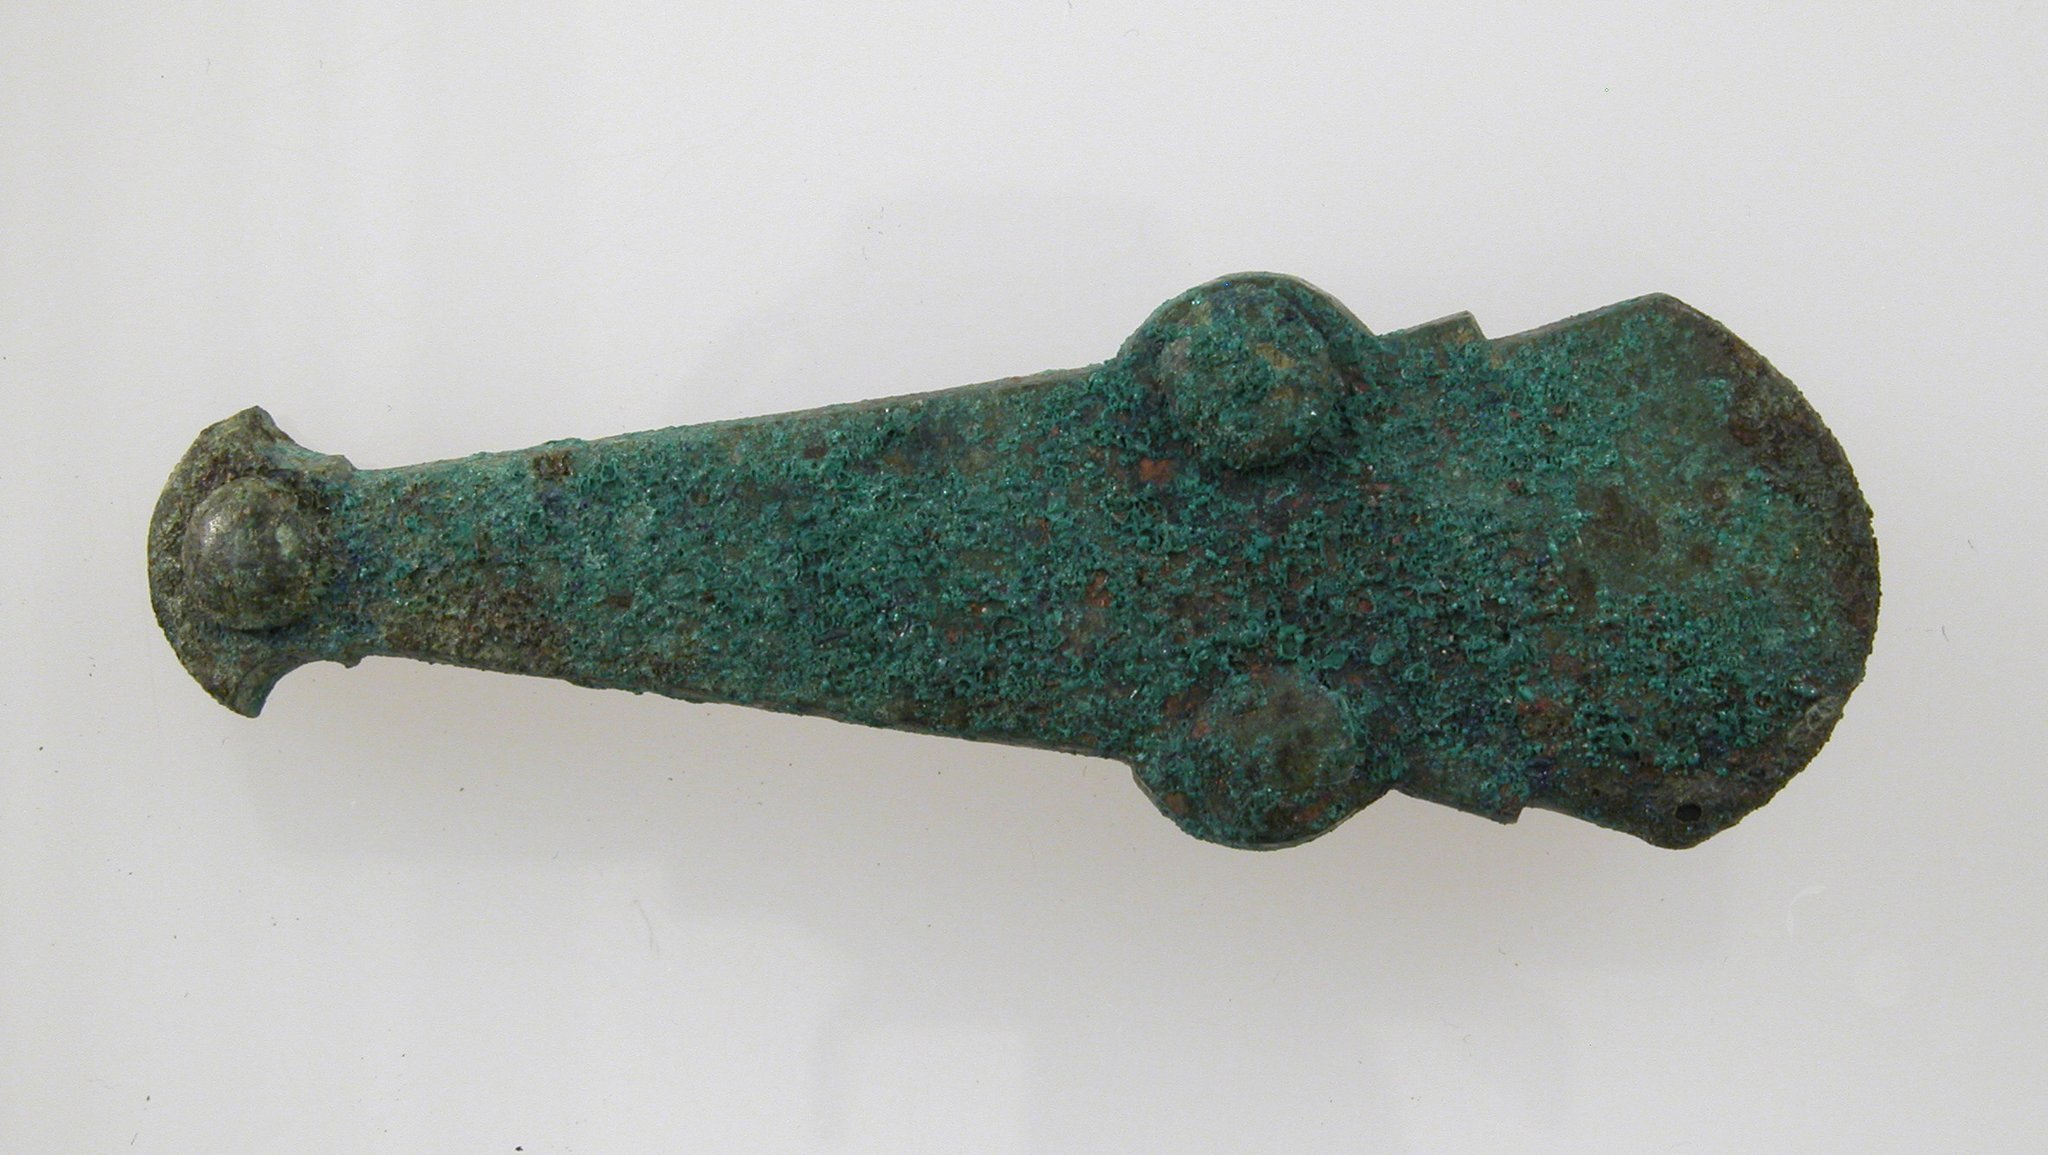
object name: plaque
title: Triangular Plaque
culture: langobardic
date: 601-700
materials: copper alloy